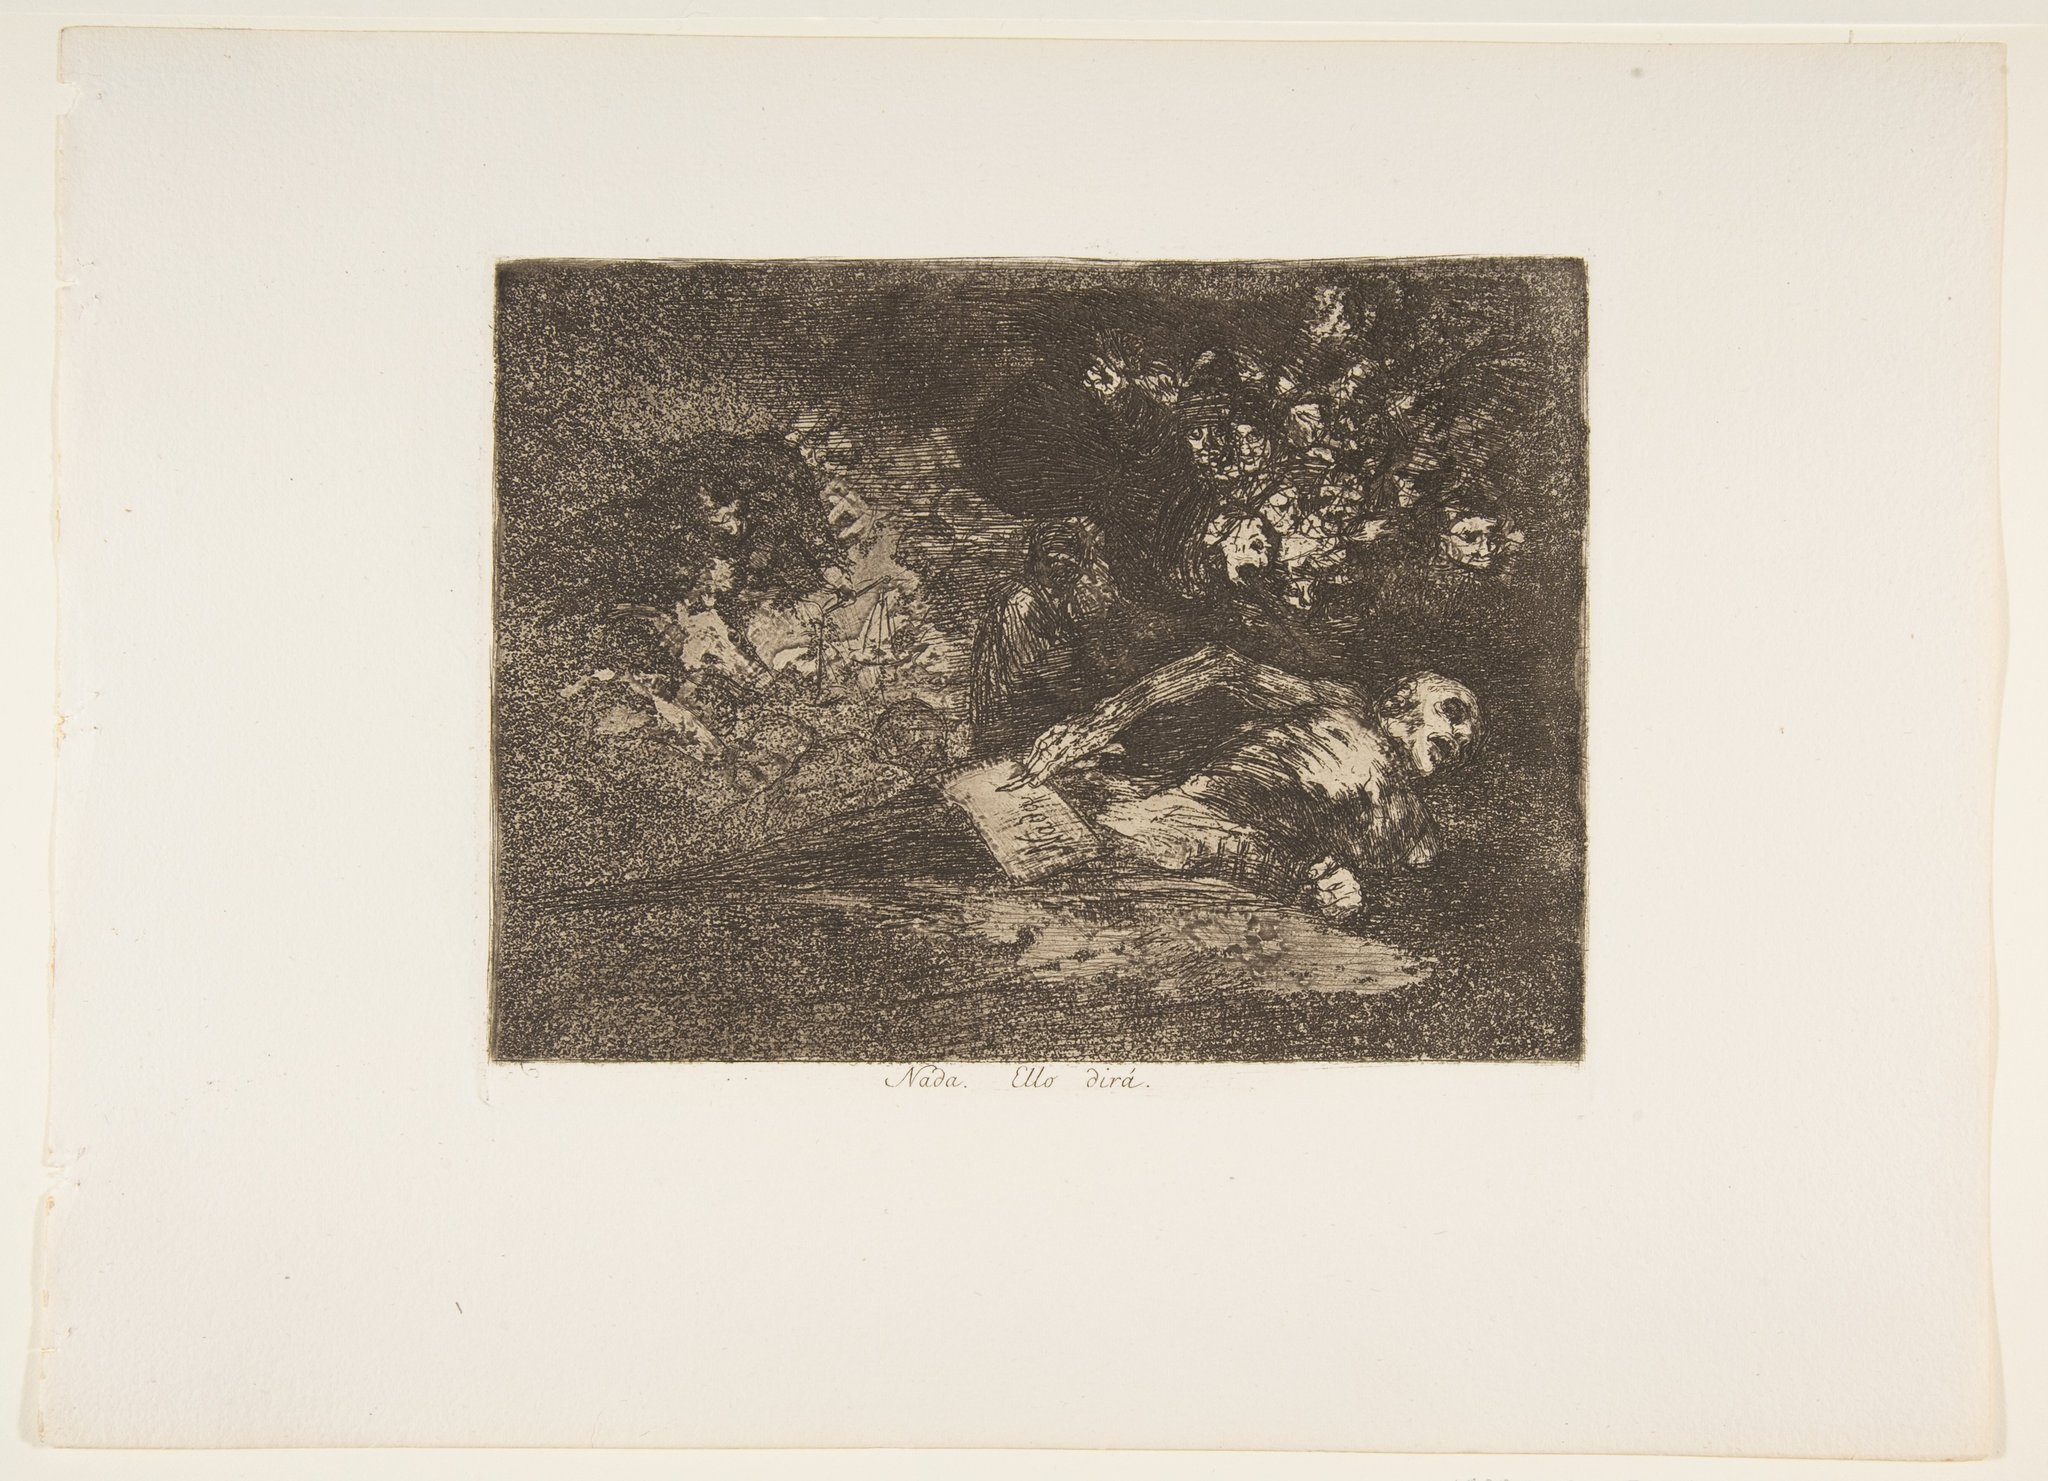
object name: print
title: Plate 69 from "The Disasters of War" (Los Desastres de la Guerra): Nothing. The event will tell (Nada. Ello dirá)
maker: goya (francisco de goya y lucientes)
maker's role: artist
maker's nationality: spanish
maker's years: 1746-1828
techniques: aquatint, engraving, burnishing, drypoint, etching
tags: corpses